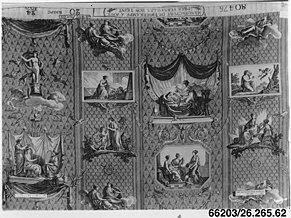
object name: furnishing textile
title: Cupid and Psyche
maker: oberkampf manufactory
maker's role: manufactory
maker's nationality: french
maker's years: 1760-1843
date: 1810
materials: cotton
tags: cupid,psyche